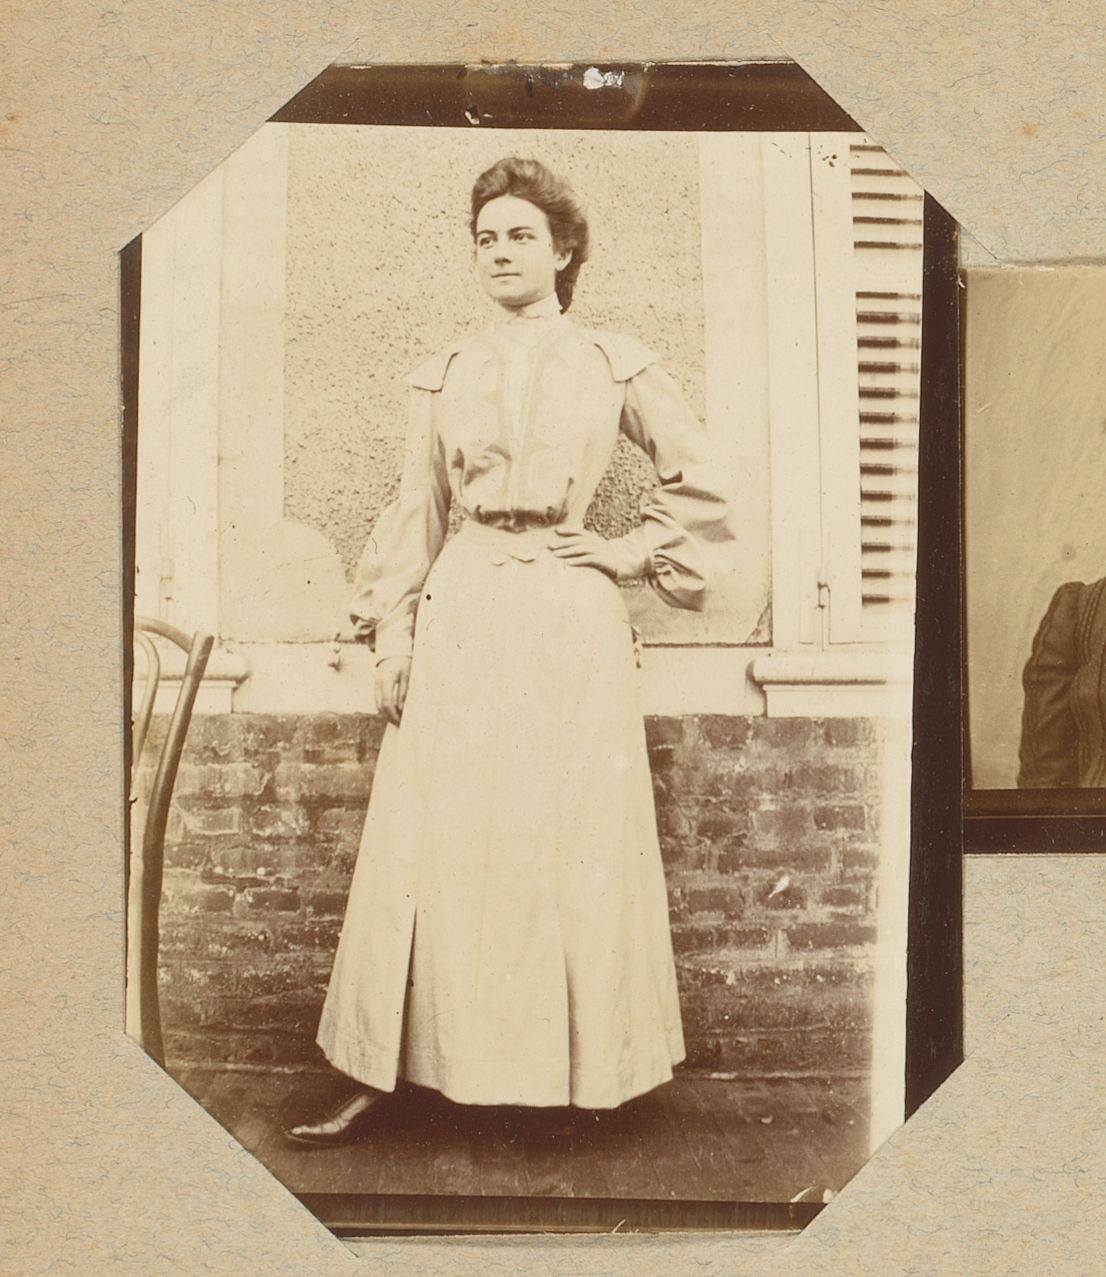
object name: photograph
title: Portret van een jonge vrouw in jurk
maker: Anonymous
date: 1897-1900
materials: paper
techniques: gelatin silver print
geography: france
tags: adolescent, young woman, maiden, historical persons, france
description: Over de foto is een ander negatief afgedrukt van een voorstelling van bomen.